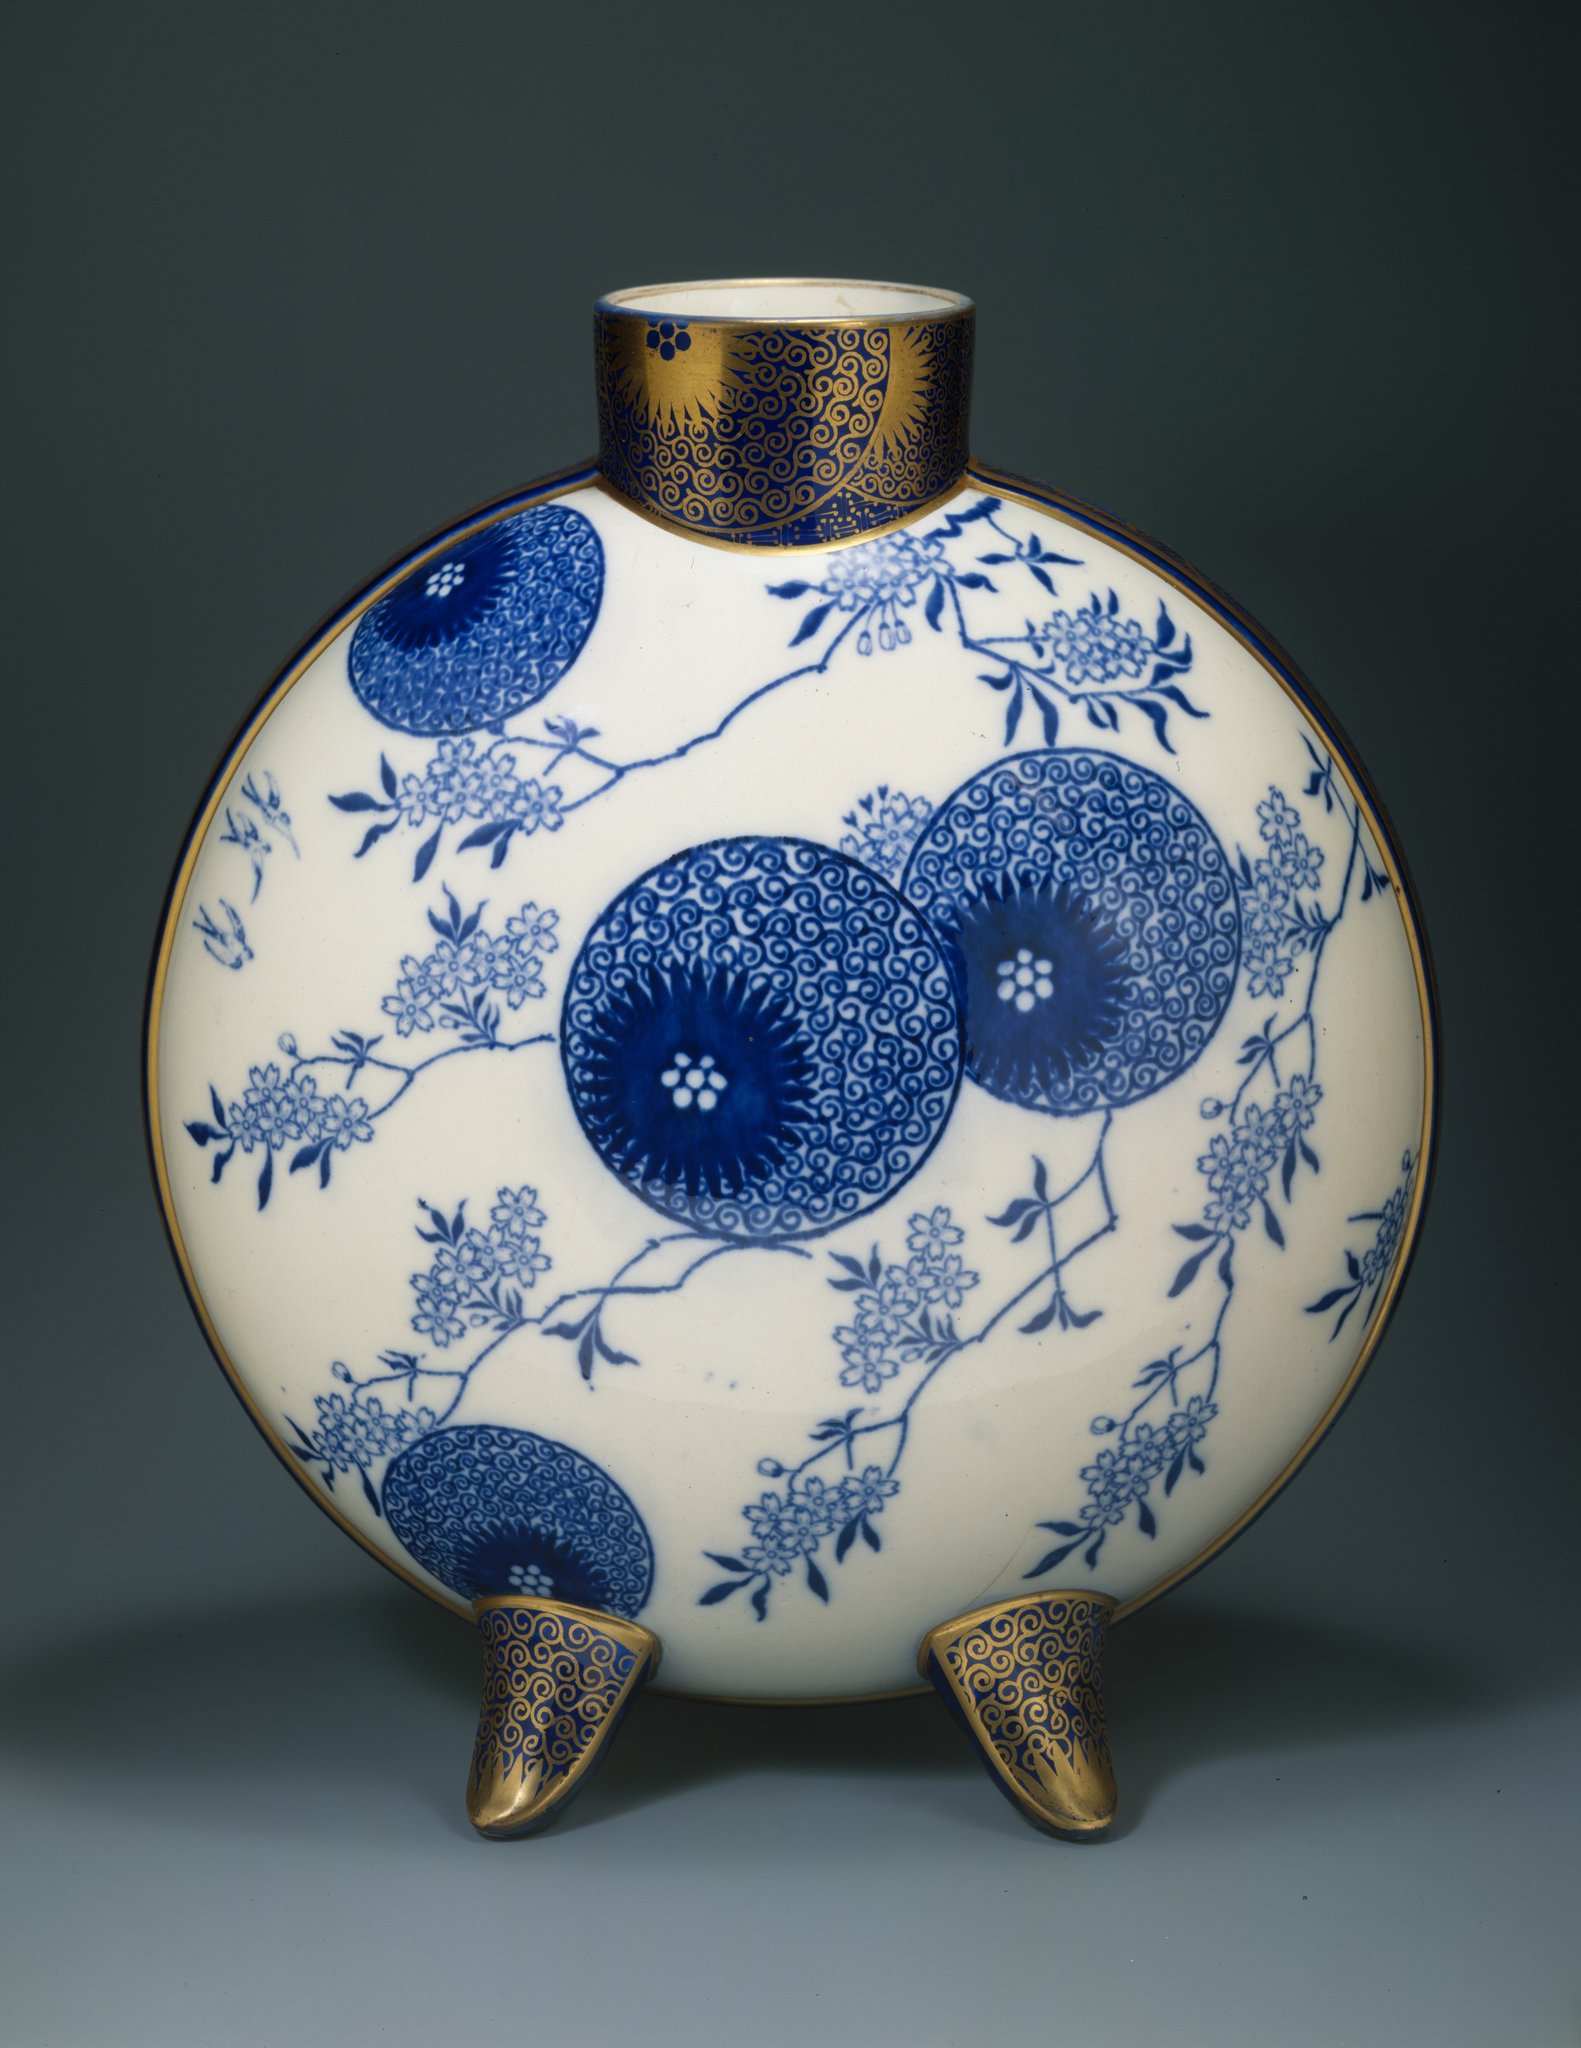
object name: moon flask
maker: henry slater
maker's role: designer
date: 1878-1882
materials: earthenware, gilt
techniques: glazing, transfer